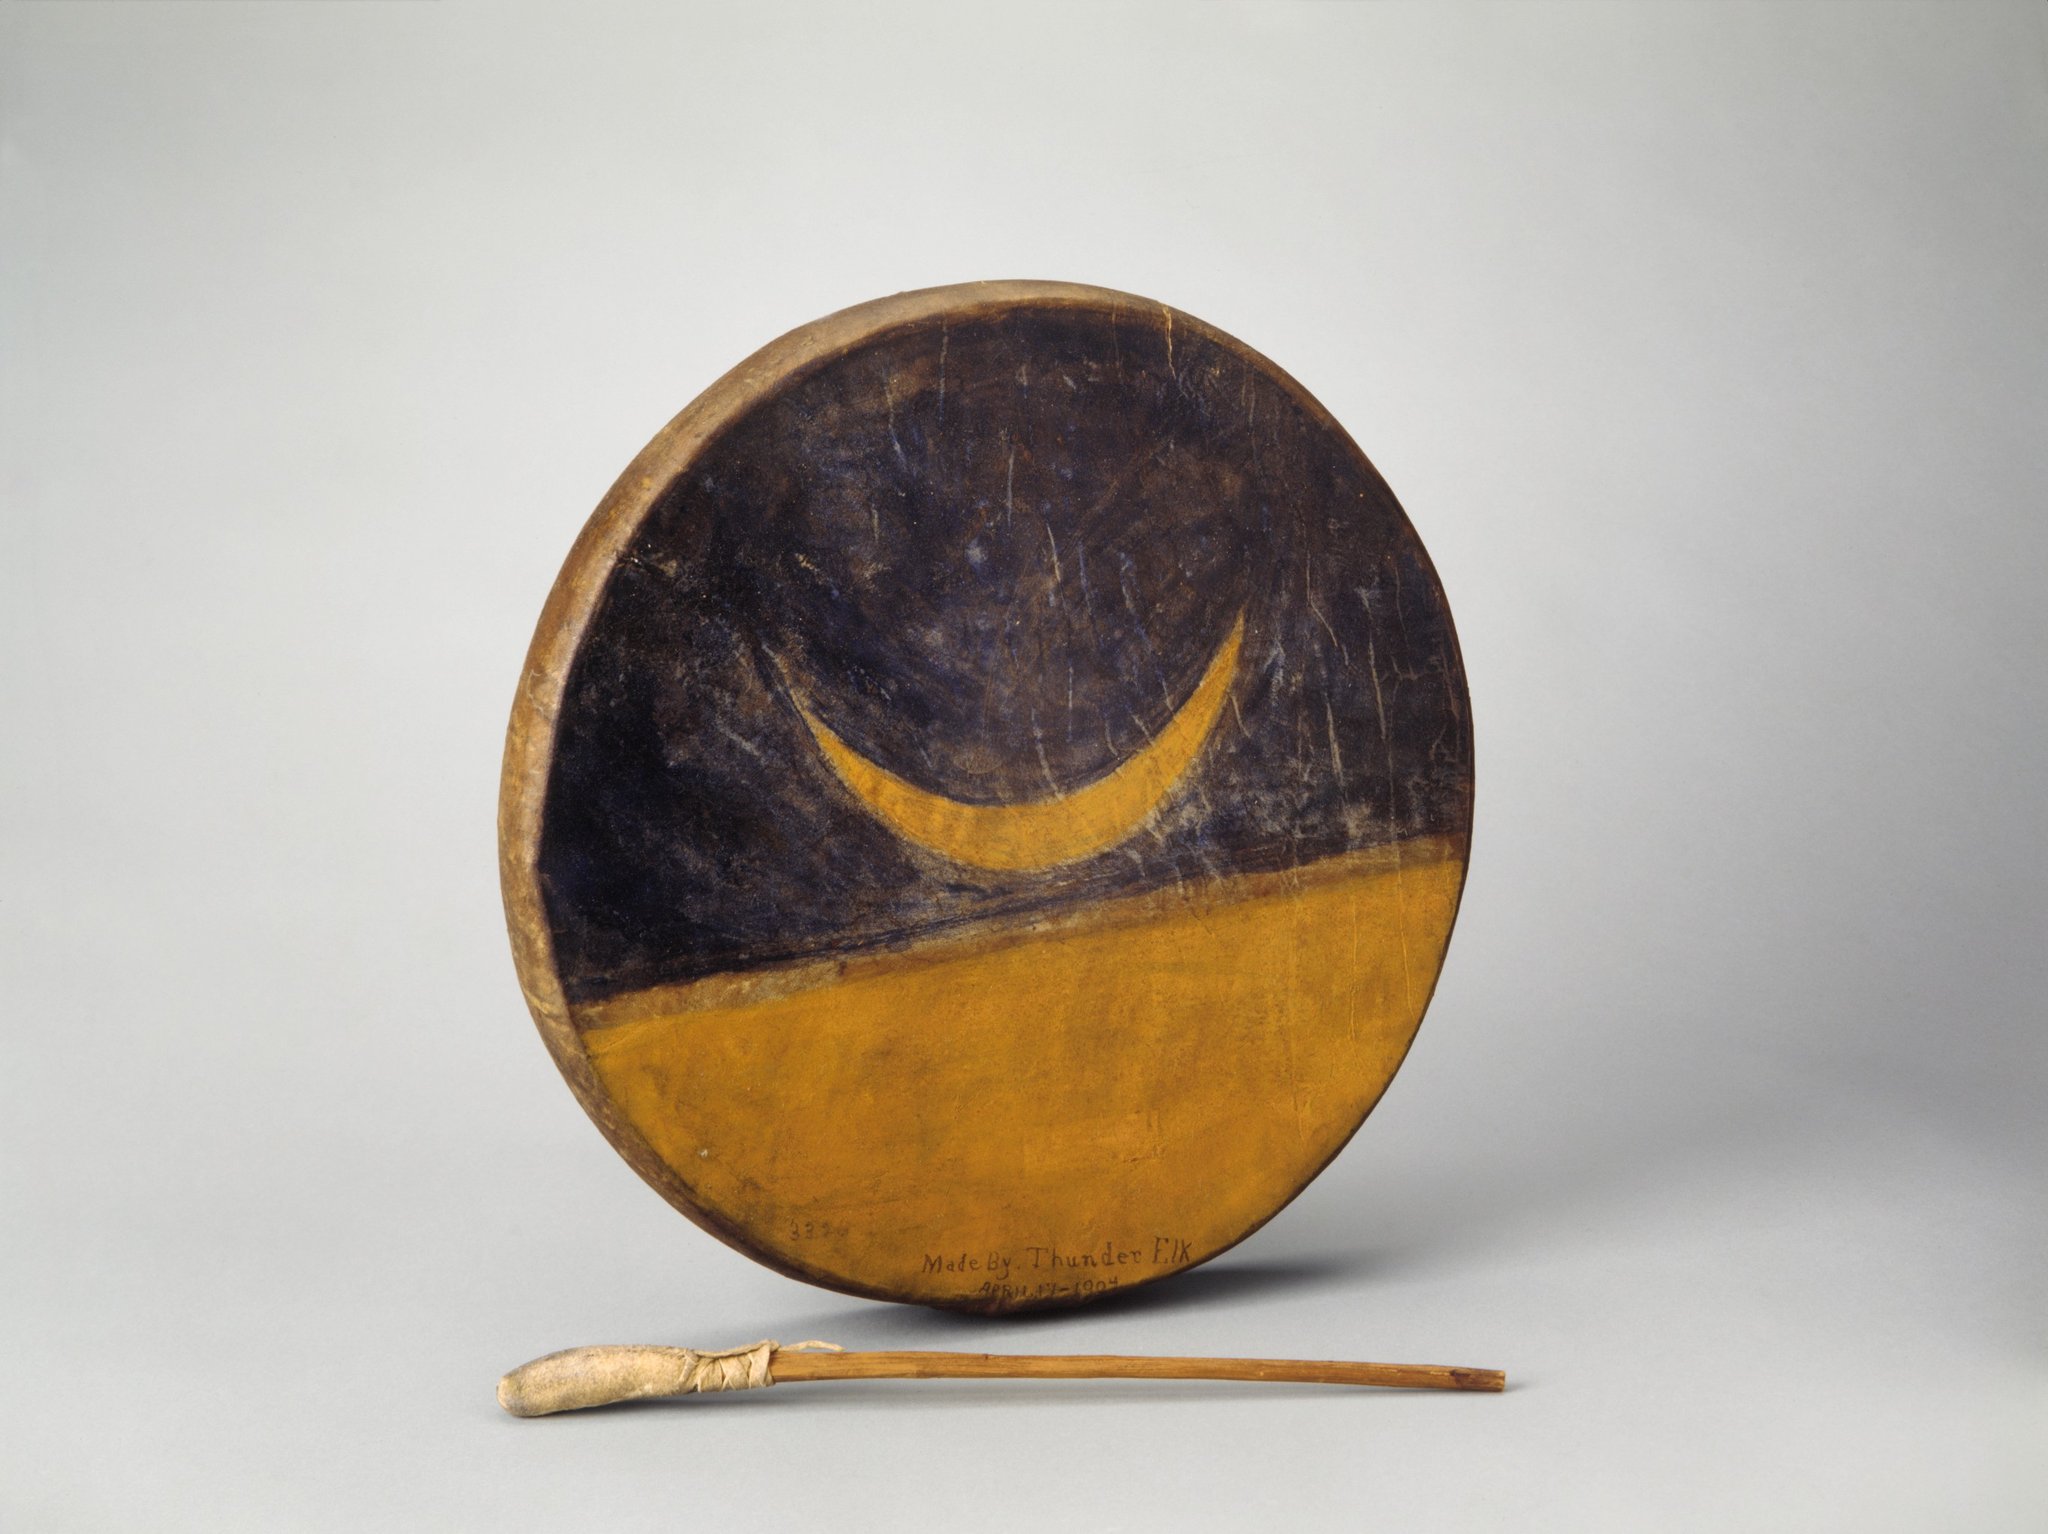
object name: frame drum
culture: native american or sioux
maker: thunder elk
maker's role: maker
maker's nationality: native american (sioux)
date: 1887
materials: leather, metal, pigment, wood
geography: united states